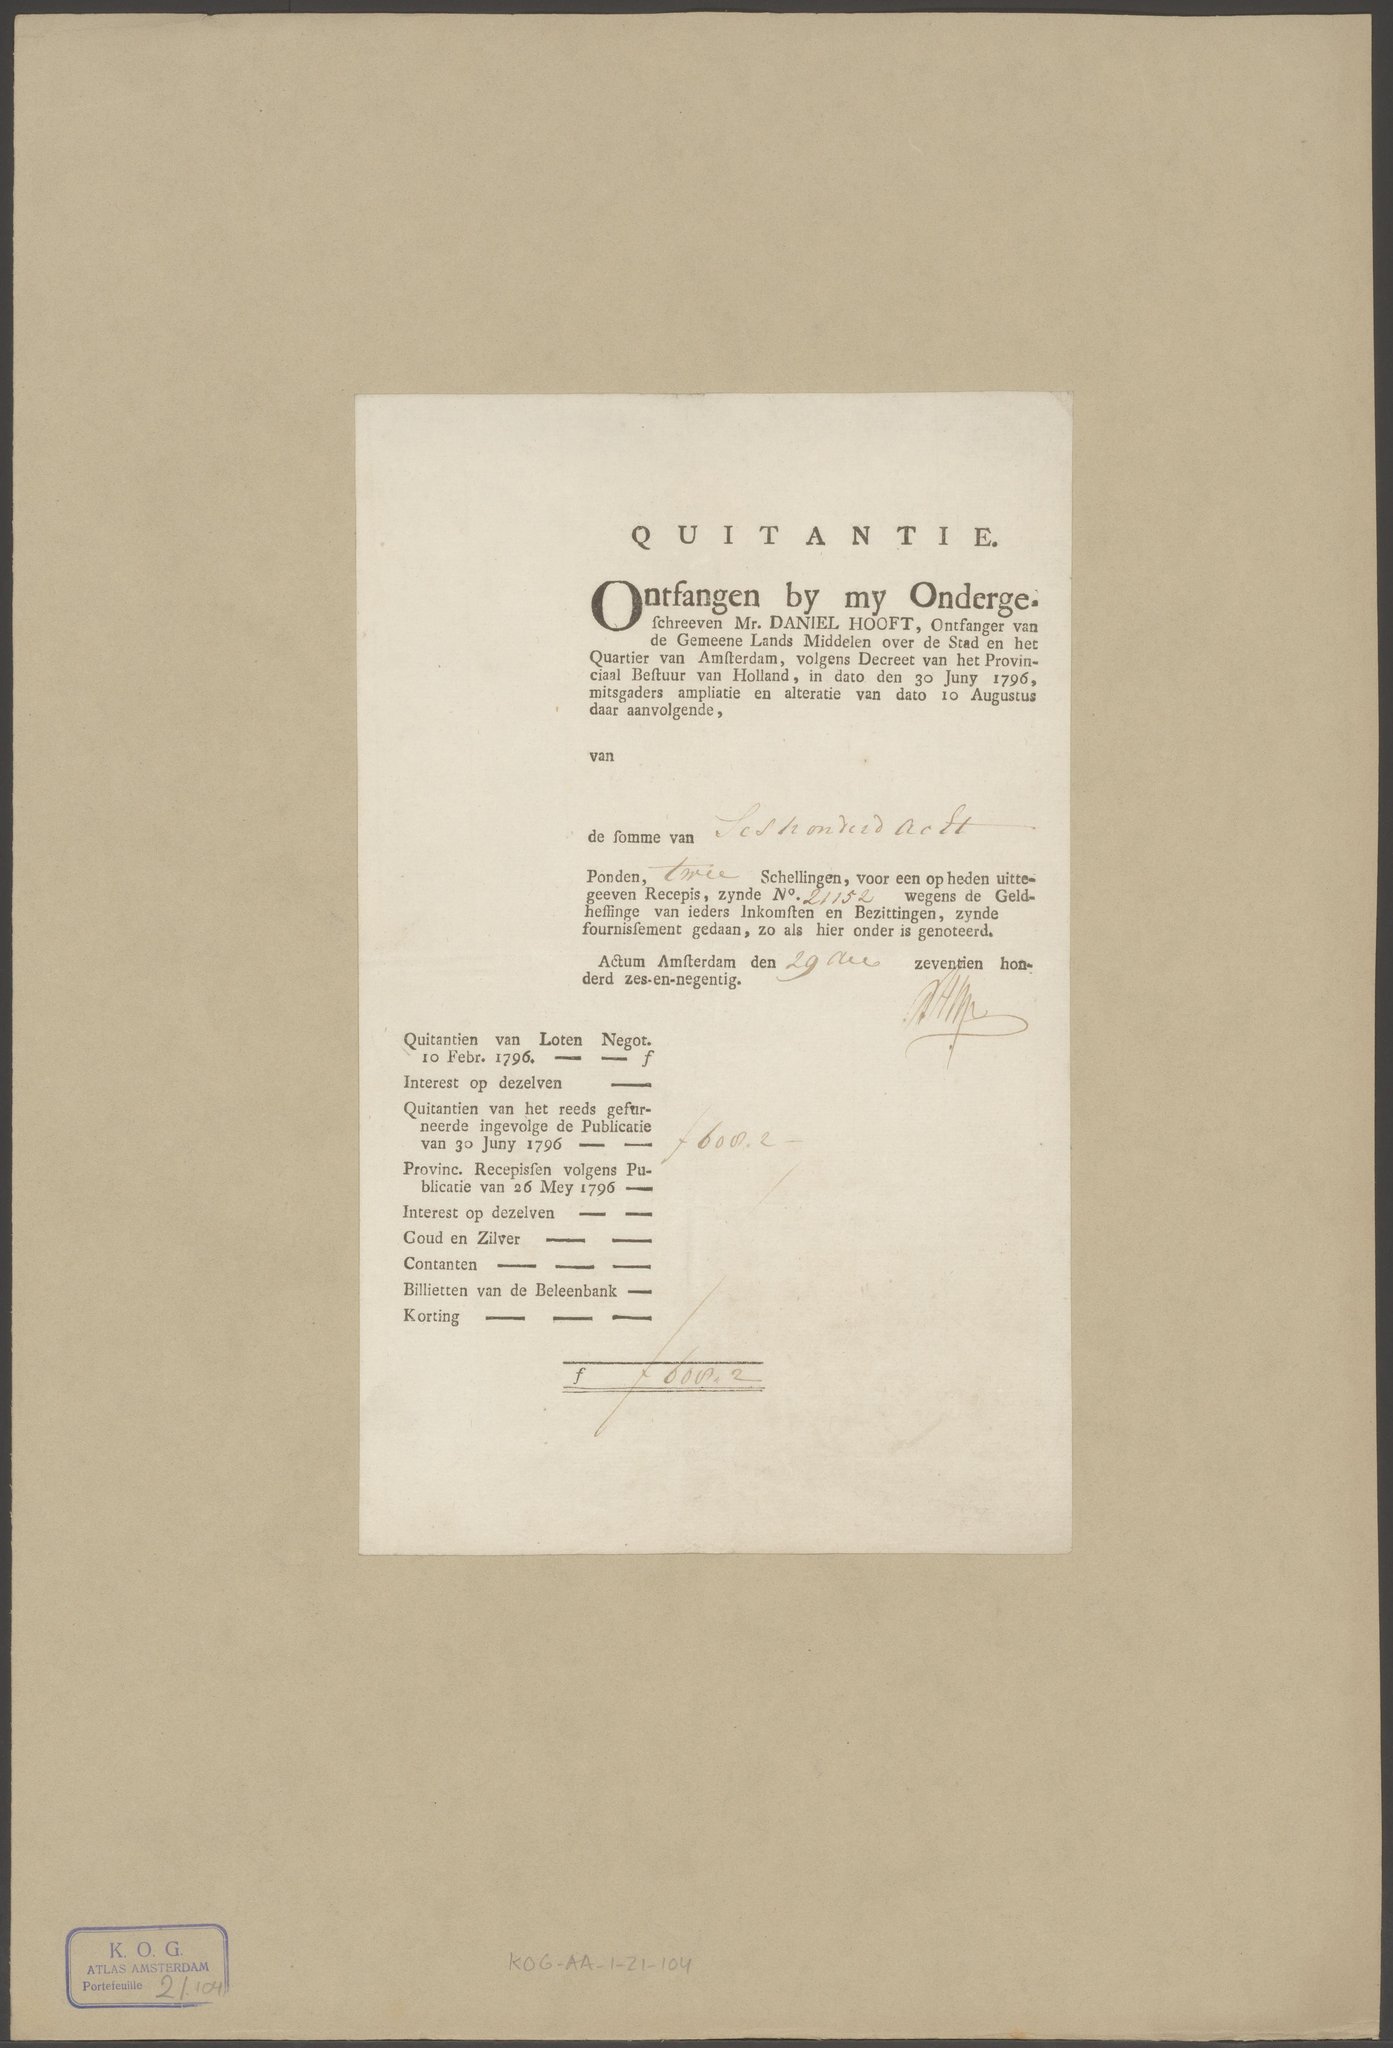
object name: document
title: Kwitantie op naam van een onbekende Amsterdammer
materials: ink, paper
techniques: letterpress printing, pen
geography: amsterdam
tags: tax collection, tax payment, amsterdam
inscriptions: collector's mark: Lugt 1641b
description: Inzake betaling van de belasting over inkomsten en bezittingen, met schriftelijke aantekening dat deze is voldaan op 29 augustus of 29 december 1796. Onderwerpsrubriek binnen de Atlas Amsterdam: Belastingen.